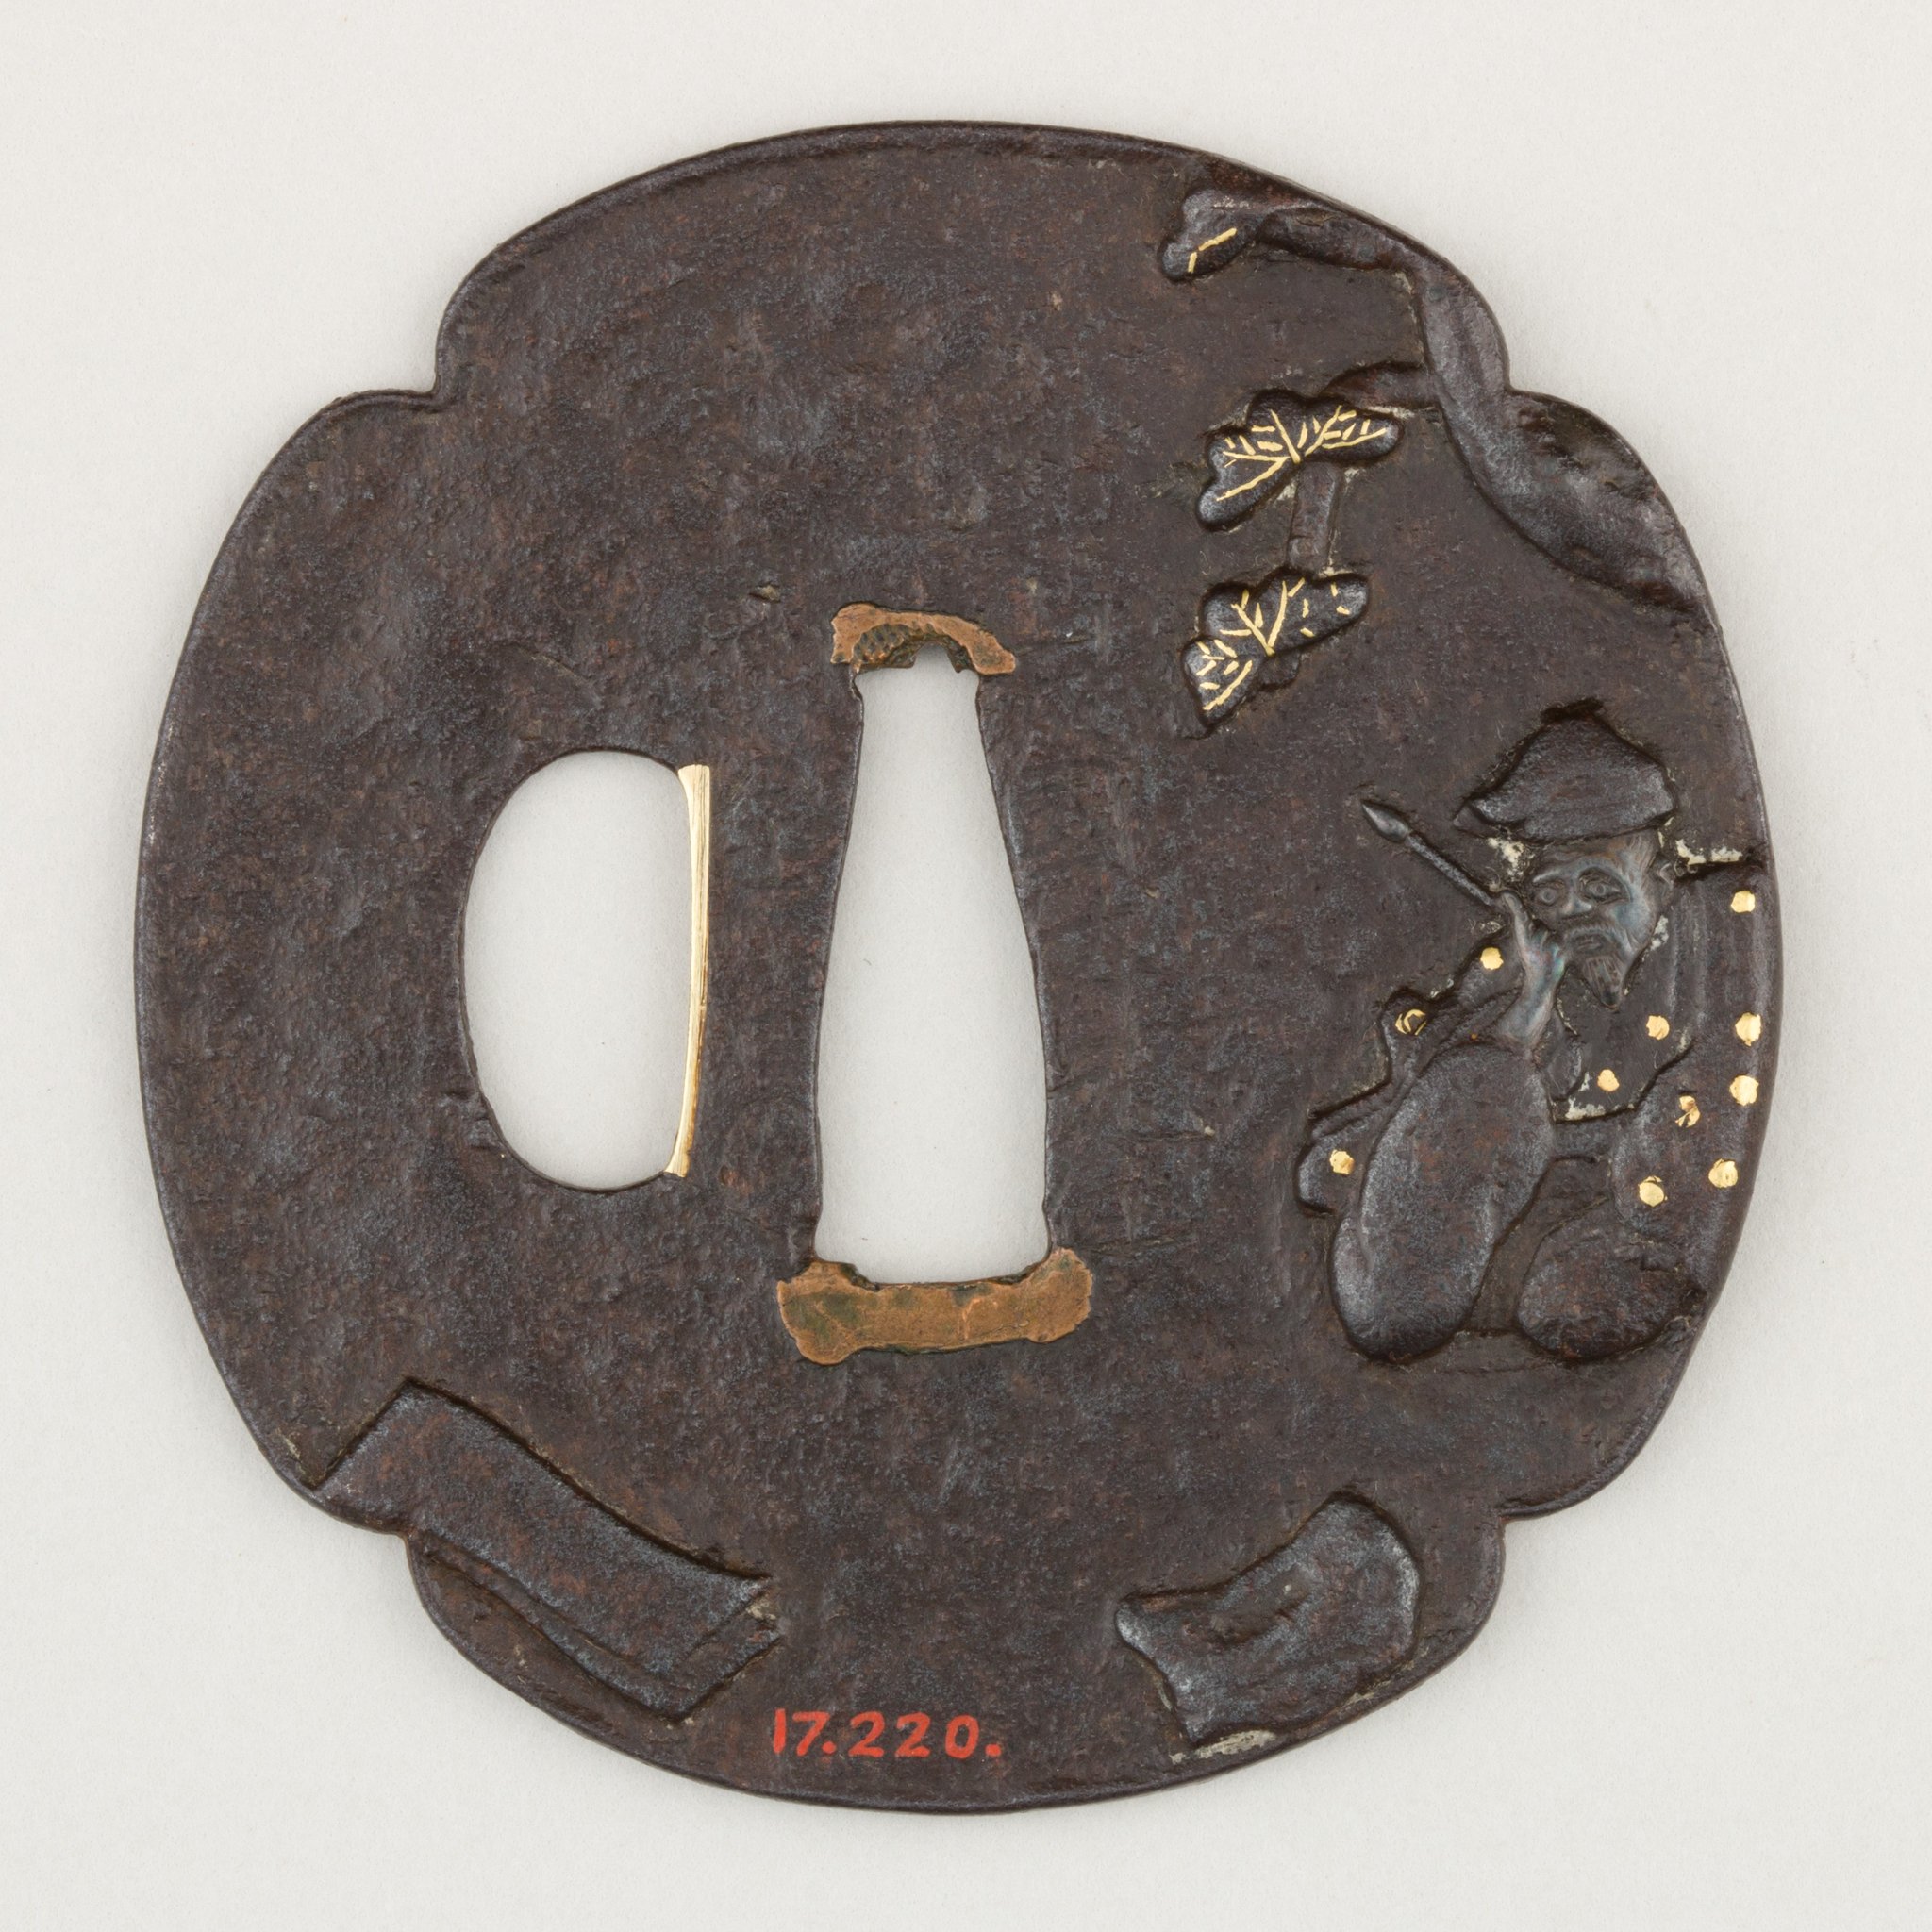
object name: sword guard tsuba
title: Sword Guard (Tsuba)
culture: japanese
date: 1667-1700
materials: copper, gold, iron, silver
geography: japan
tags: men